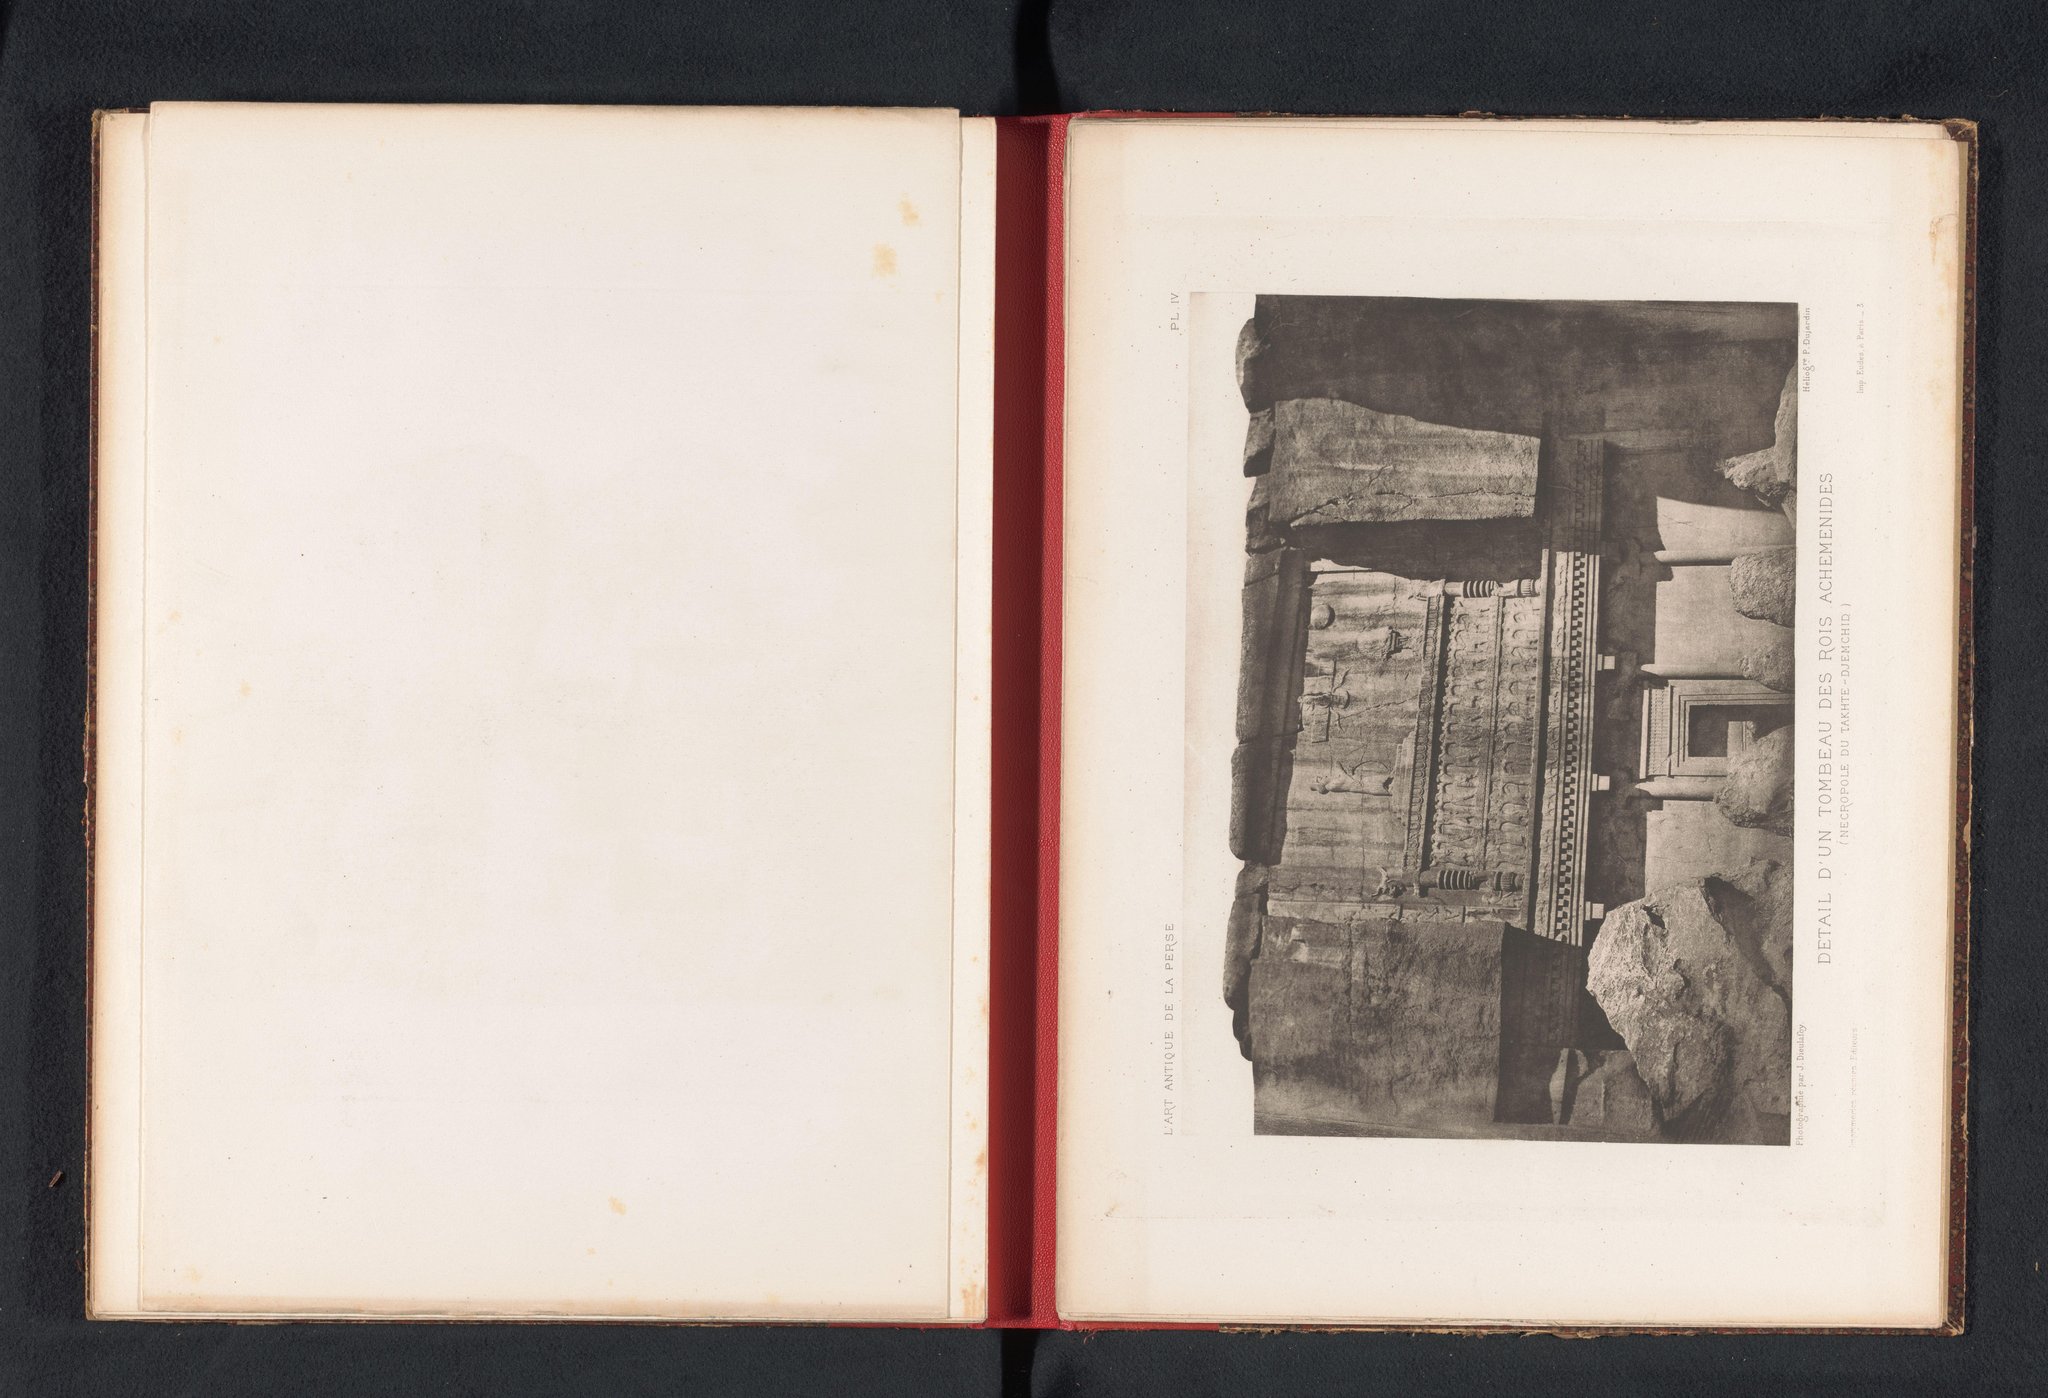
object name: photomechanical print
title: Detail d'un Tombeau des Rois Achemenides (Necropole du Takhte-Djemchid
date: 1880-1885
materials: paper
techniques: photoaquatint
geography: paris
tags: niche-tomb, wall-tomb, necropolis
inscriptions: number: ‘PL. IV’, inscription: ‘Imprimeries réunies_Editeurs. Imp. Eudes, à Paris_3.’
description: Deze prent maakt deel uit van een omslag met twintig prenten op zeventien bladen en vijftien tekstbladen.